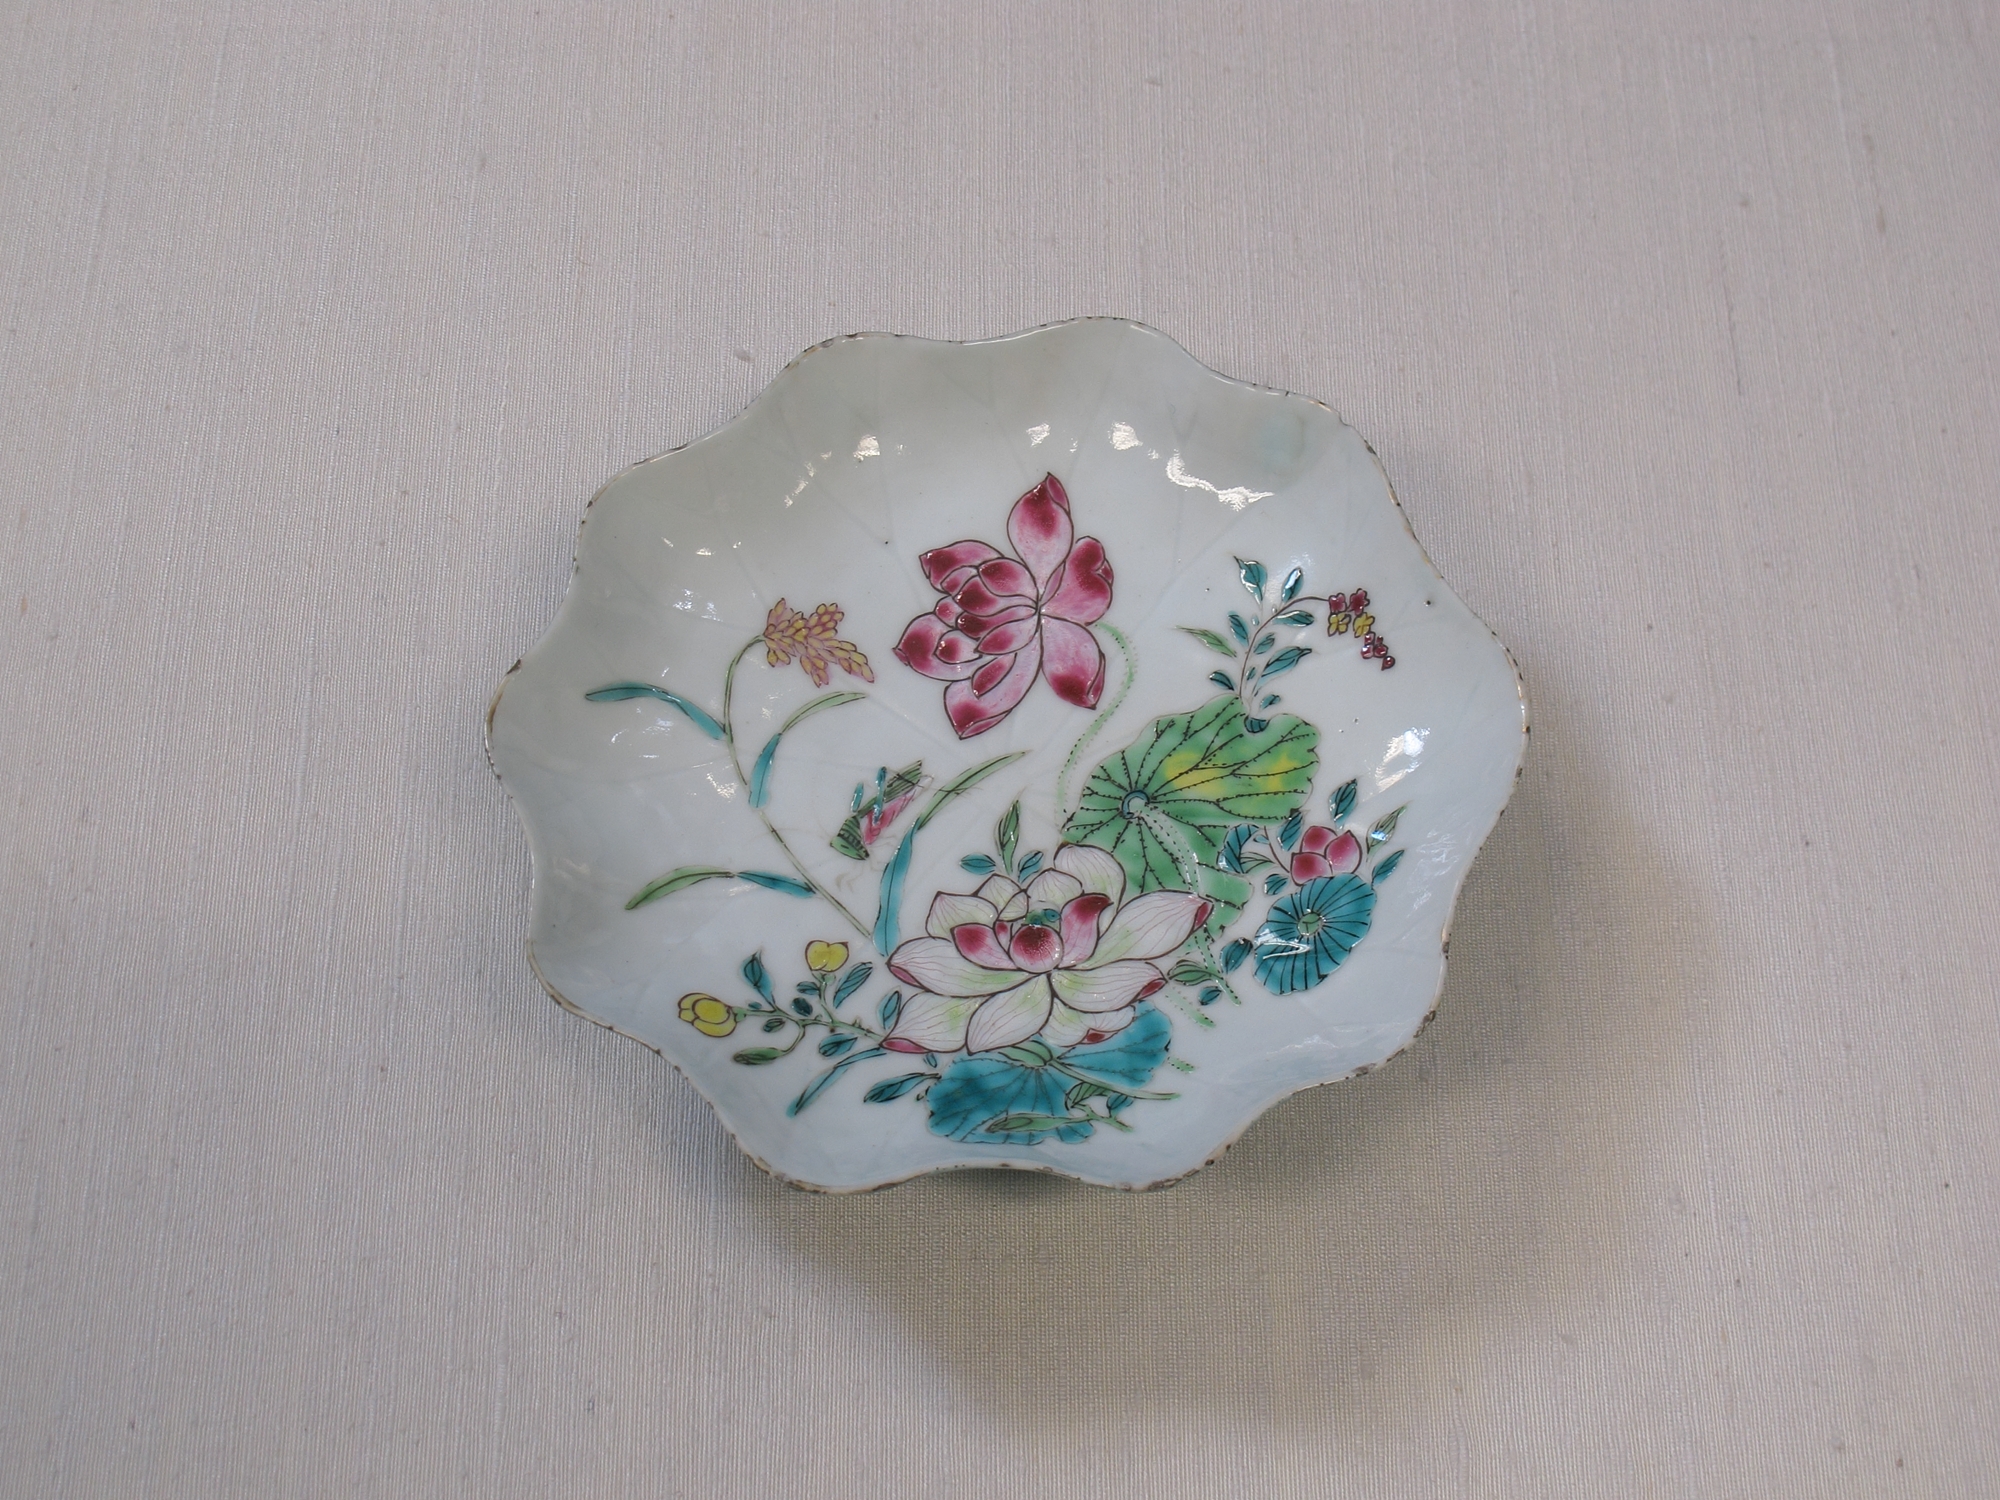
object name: dish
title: Lotus dish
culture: chinese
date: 1801-1850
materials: enamel, porcelain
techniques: overglaze, painting, polychrome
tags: flowers